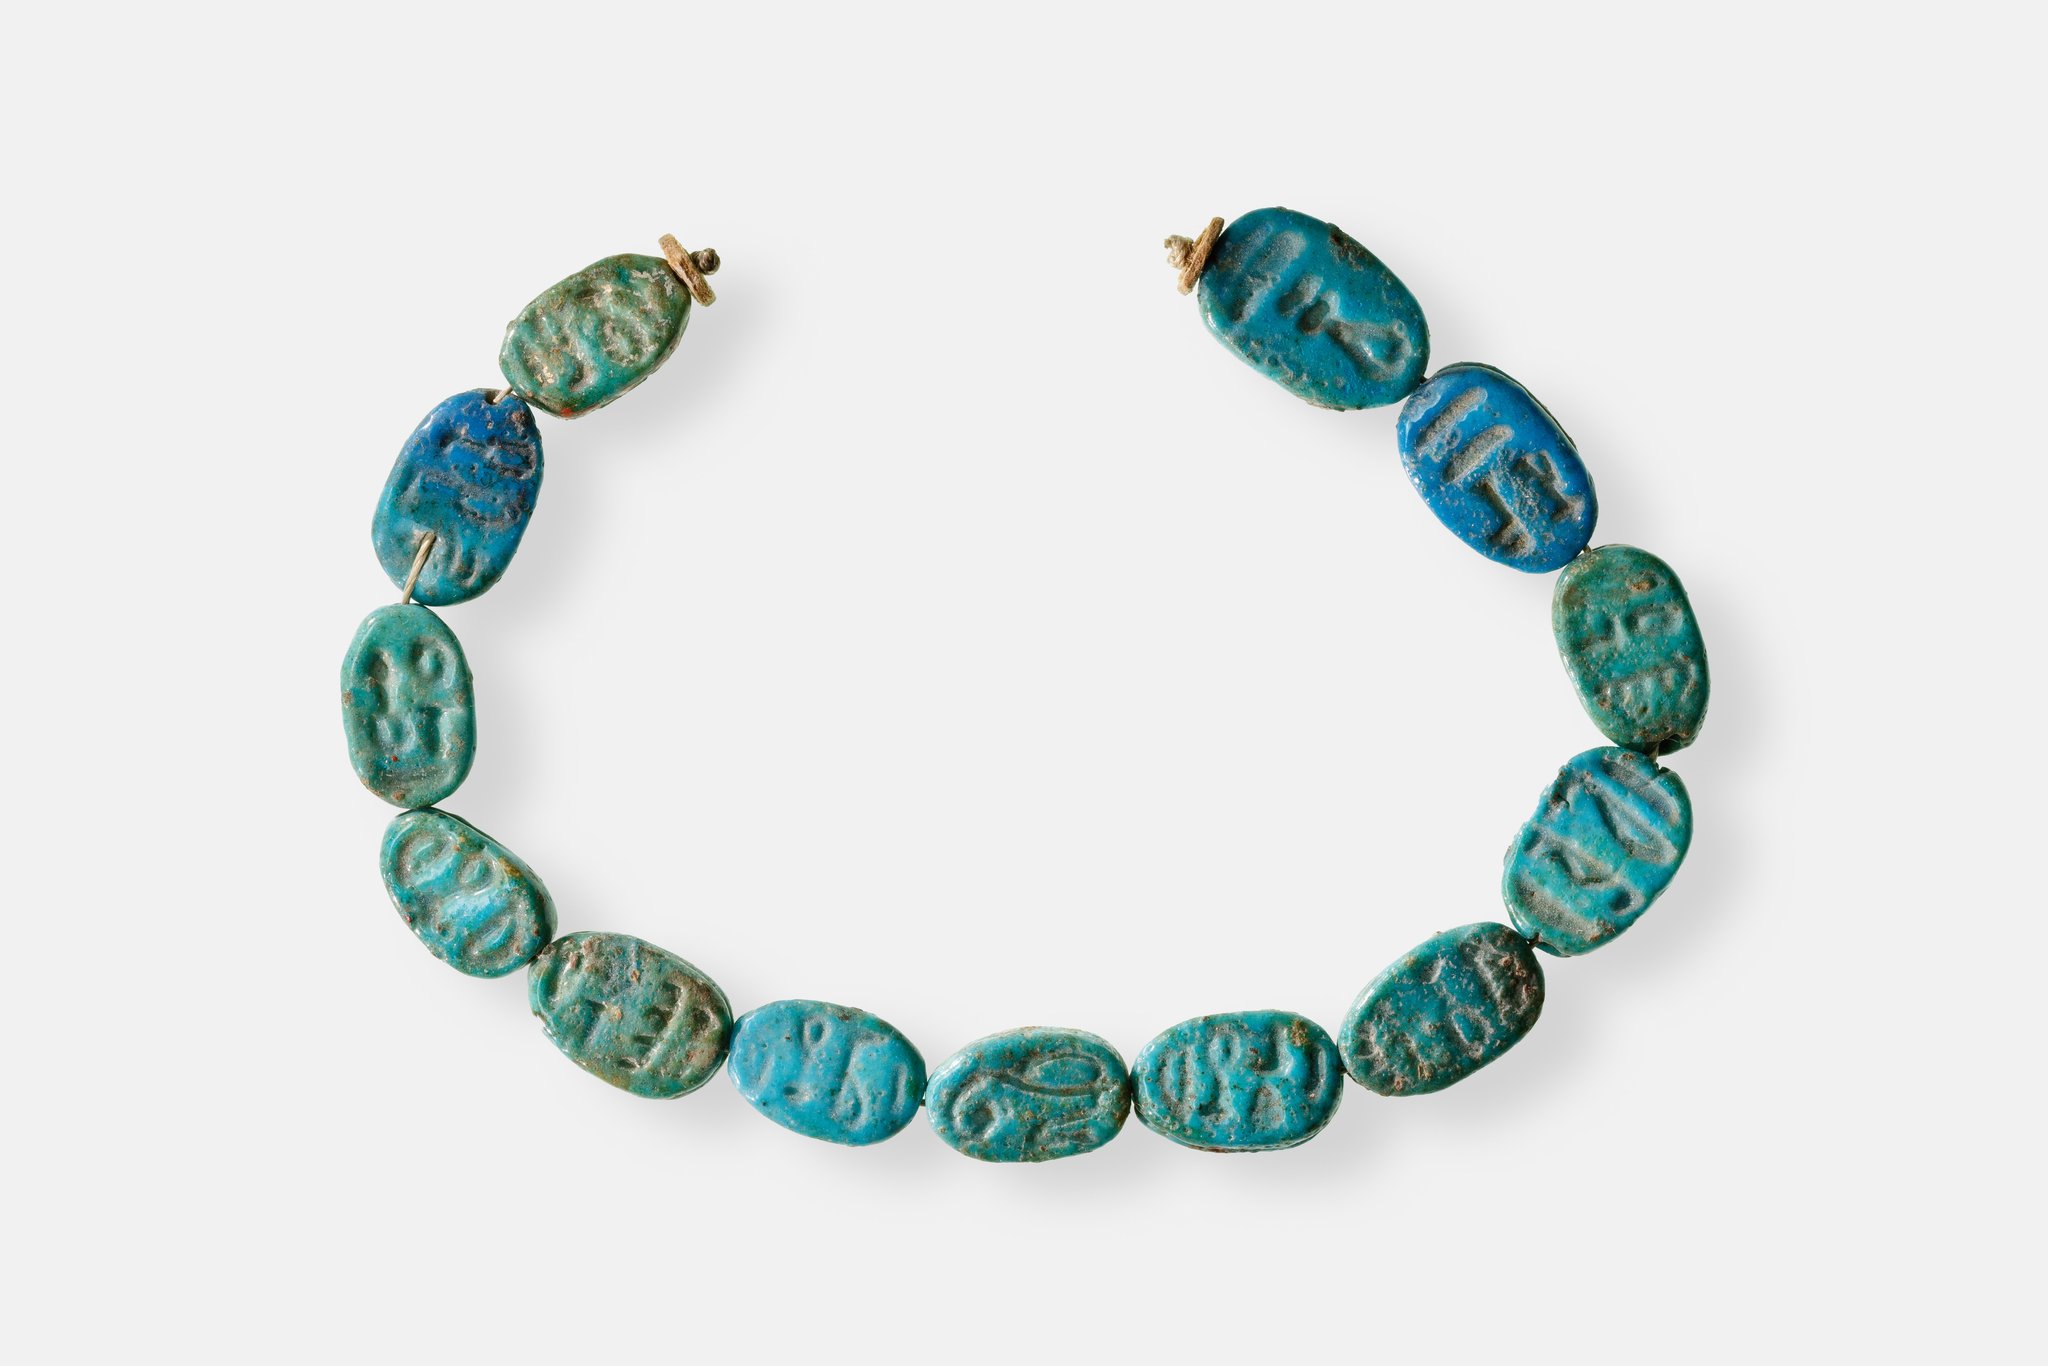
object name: scarab, amenemhat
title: Strand of Inscribed Scarabs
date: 1504-1447 BCE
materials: faience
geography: egypt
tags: hieroglyphs,scarabs